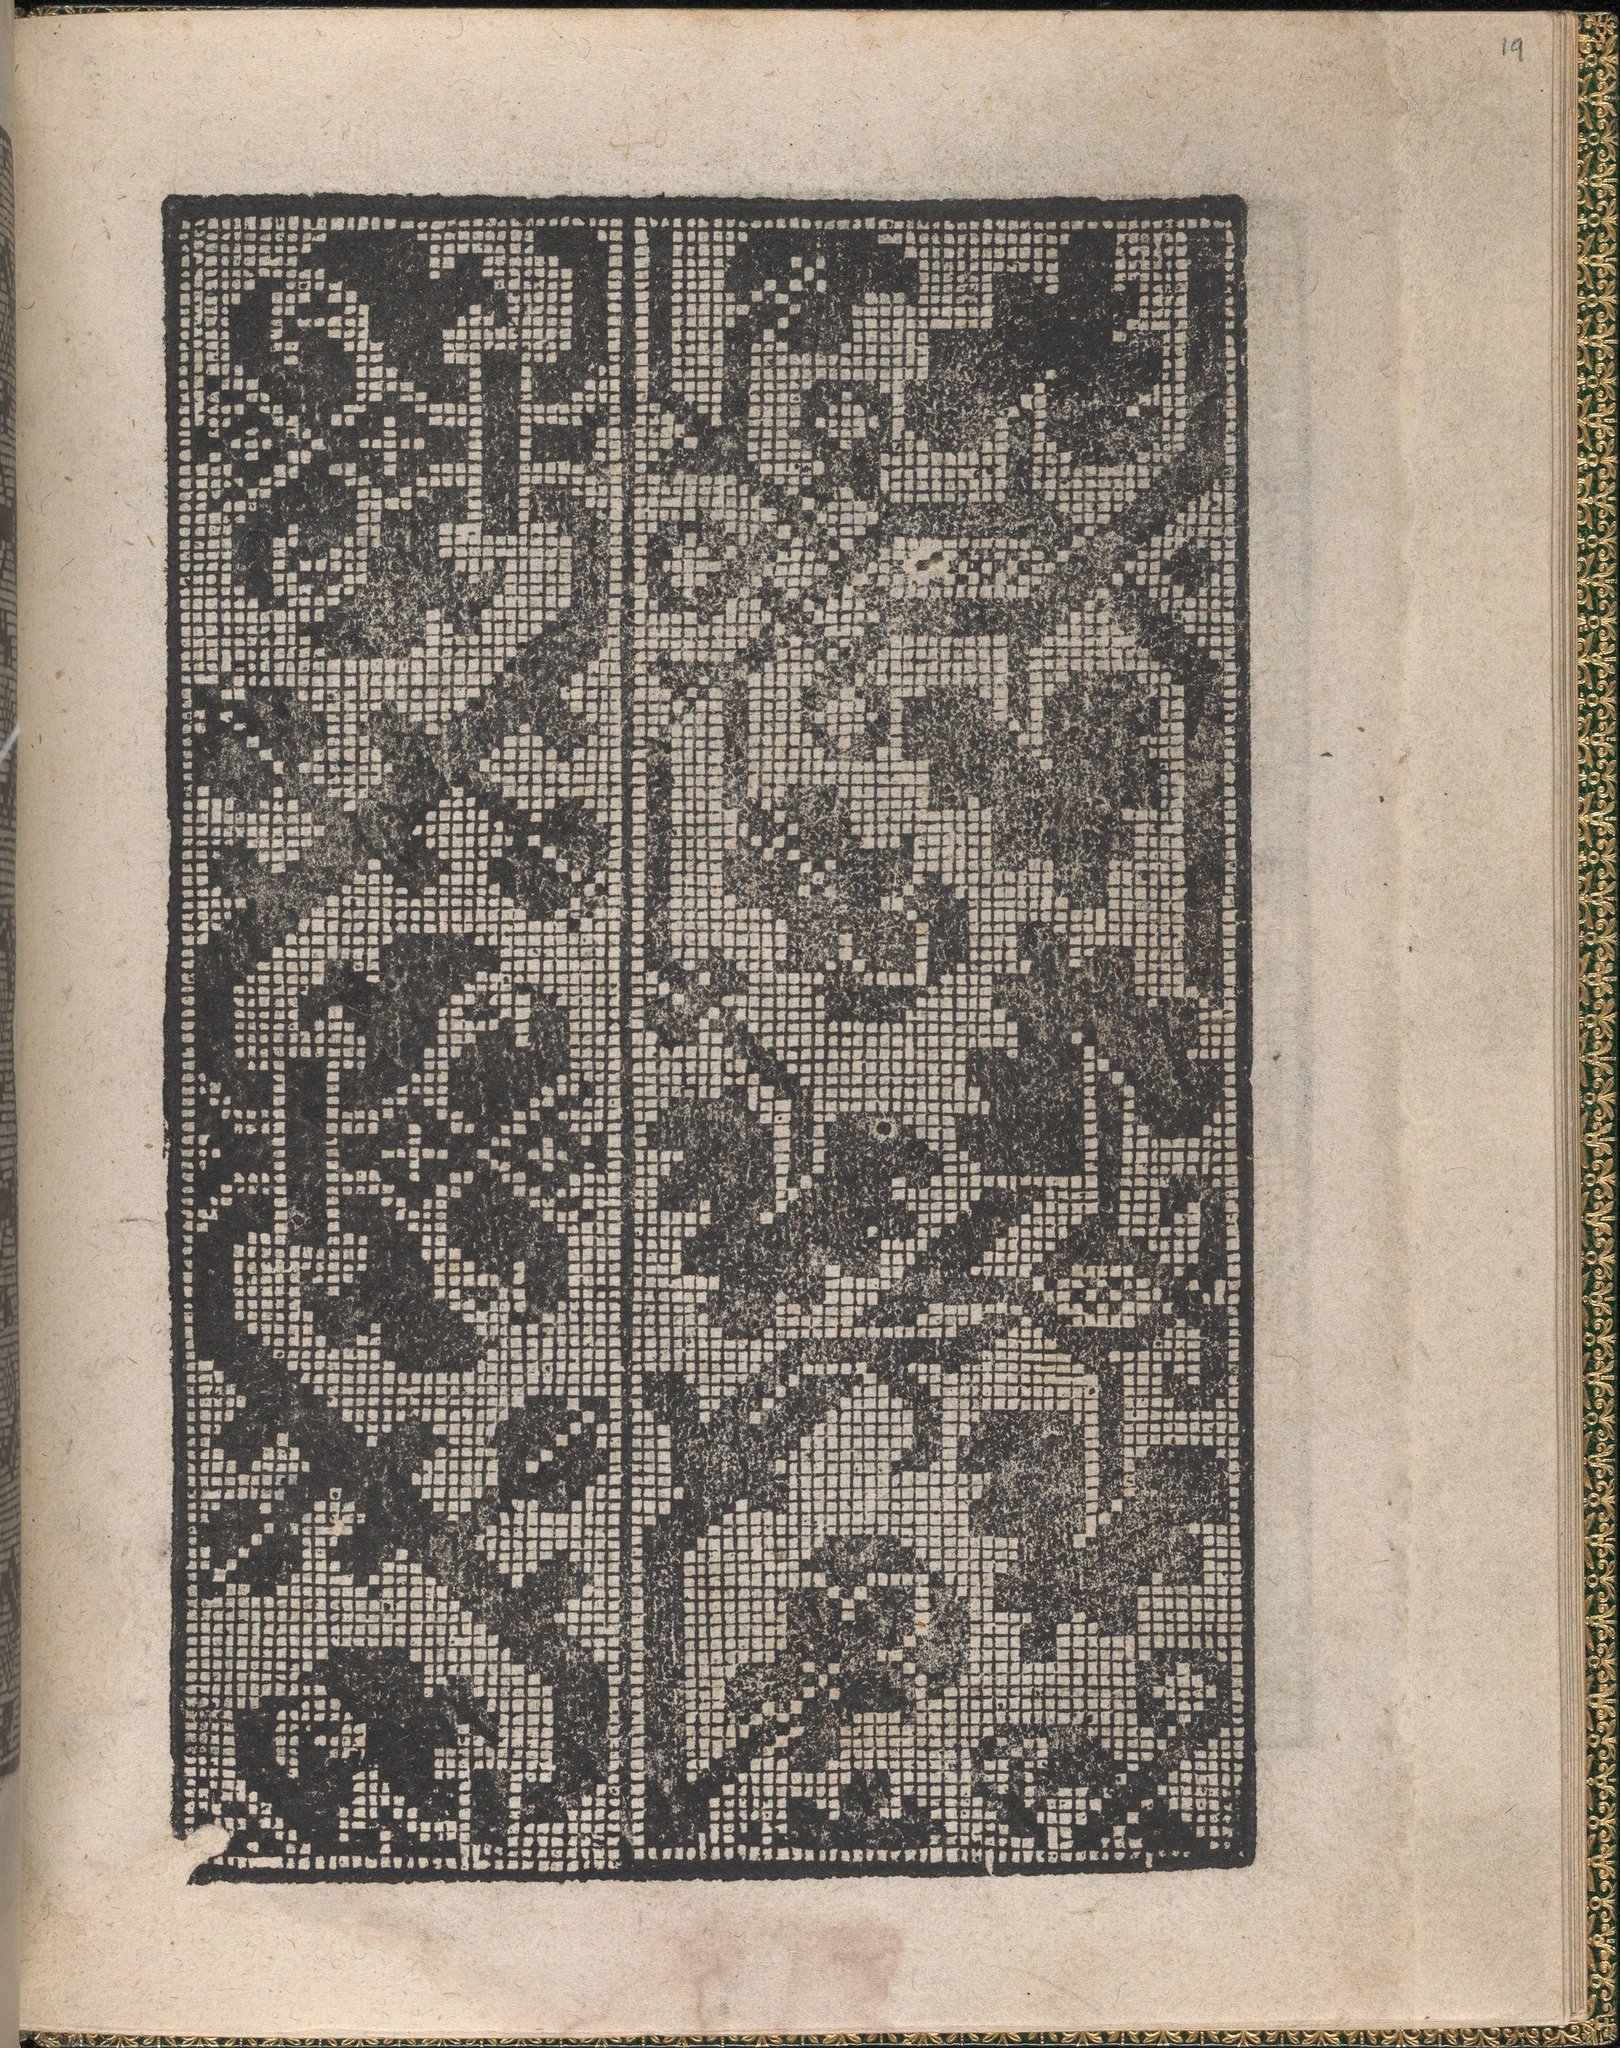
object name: book print ornament architecture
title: Ornamento delle belle & virtuose donne, page 10 (verso)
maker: matteo pagano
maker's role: publisher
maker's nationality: italian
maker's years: 1515-1588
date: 1554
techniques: woodcut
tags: ornament